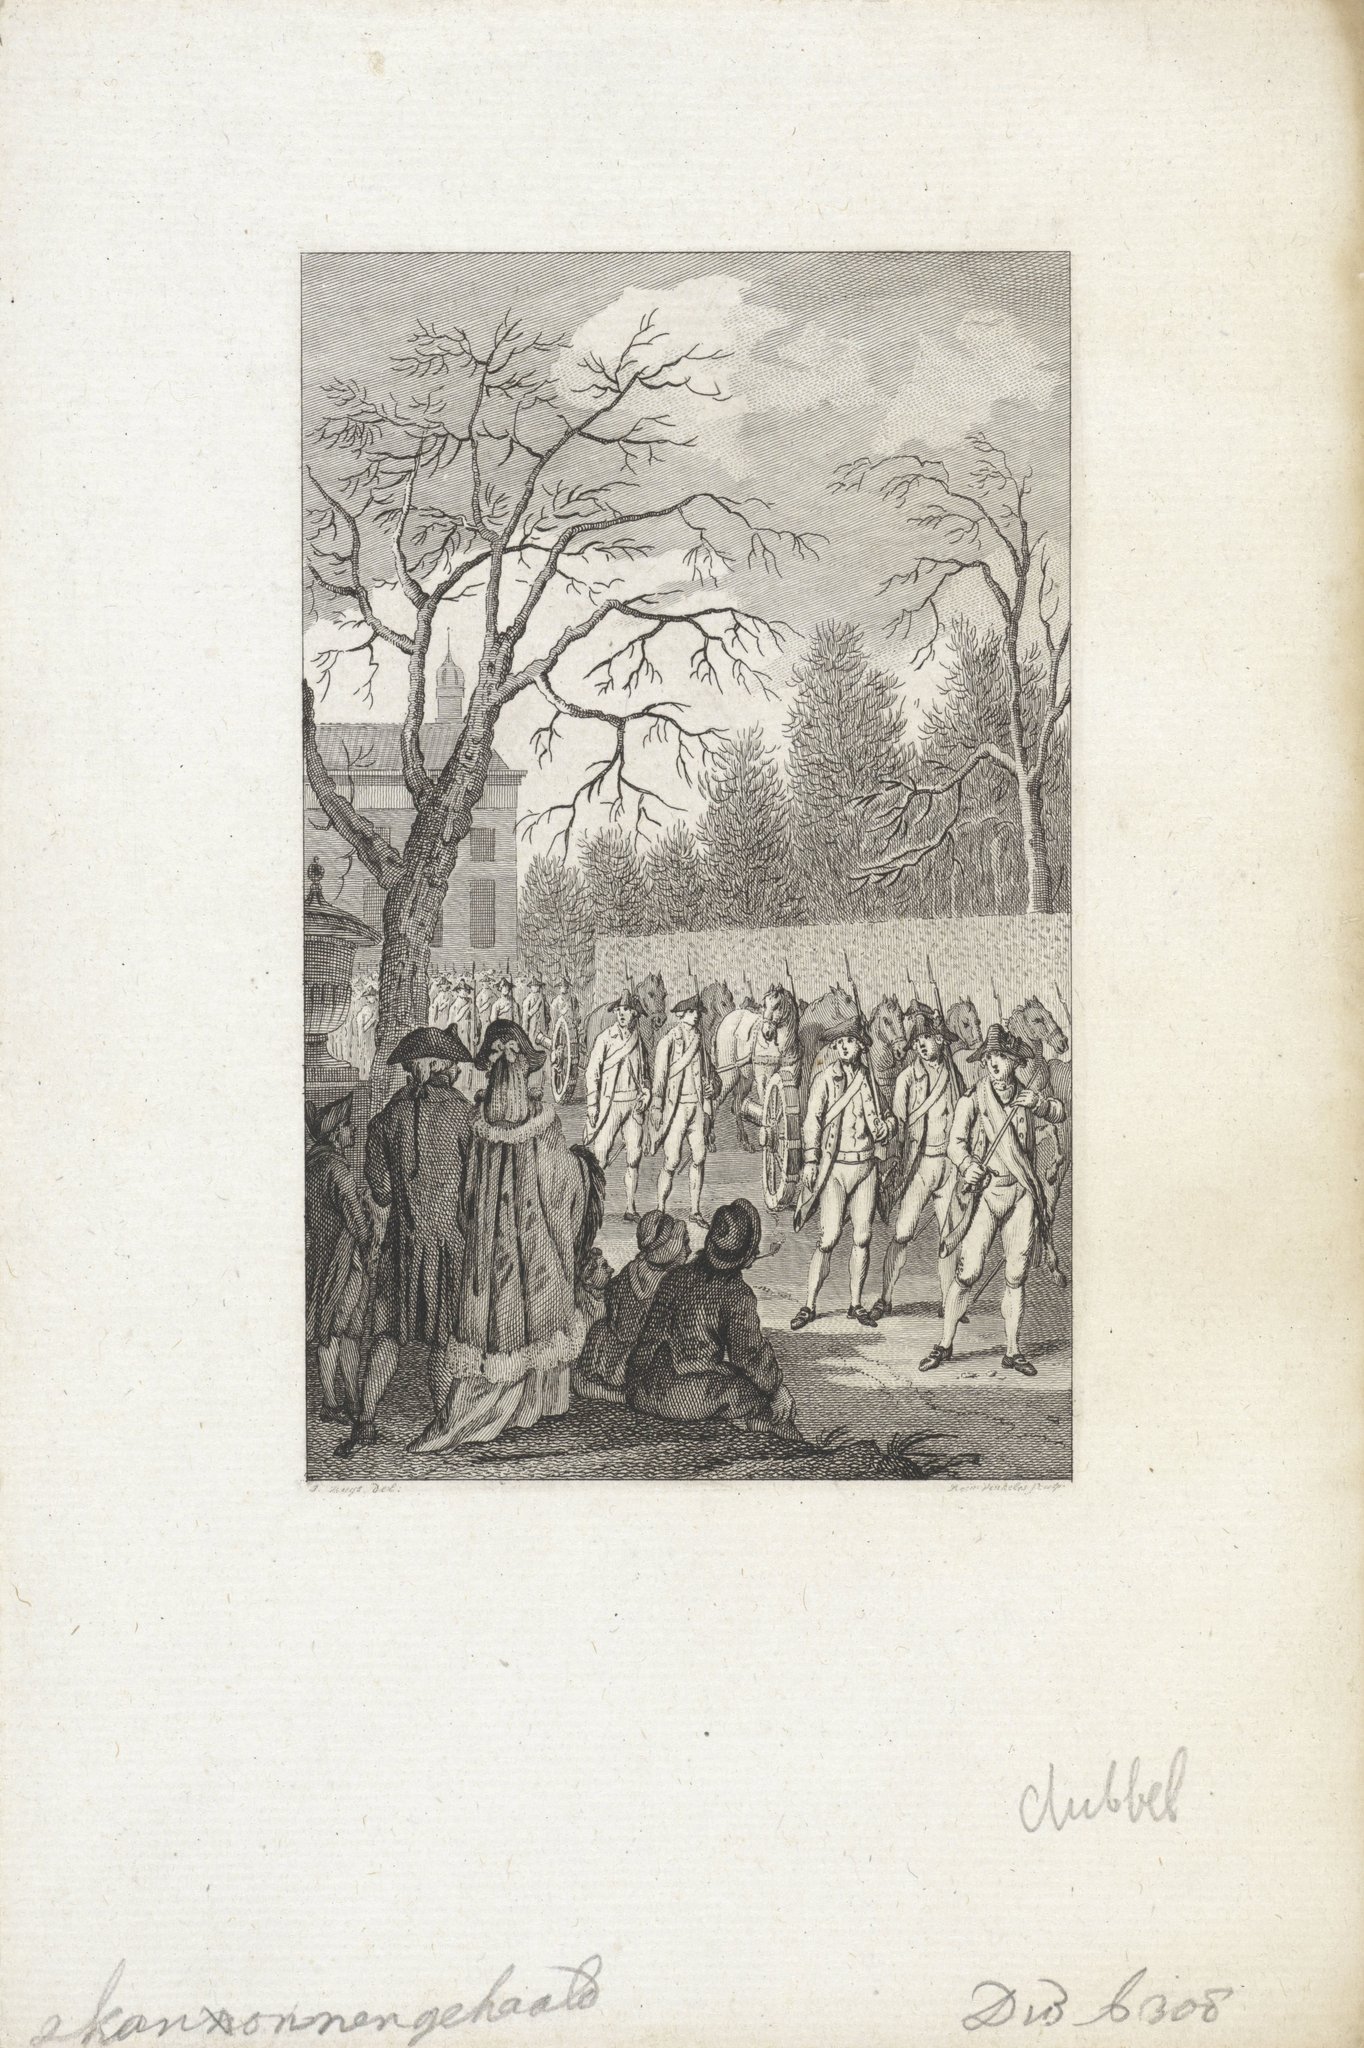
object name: print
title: Weghalen van kanonnen uit het Huis de Gelder, 1785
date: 1793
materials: paper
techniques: engraving, etching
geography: amsterdam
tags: warfare; military affairs (+ citizen soldiery, civil guard, citizen militia), deventer, wijhe, patriots (1780-1795)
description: De leden van de vrijkorps van Deventer, aan wie de twee kanonnen door jhr. Frederik Gijsbert van Dedem tot den Gelder geschonken zijn, halen plechtig de stukken geschut op uit het Huis de Gelder te Wijhe, 31 januari 1785.